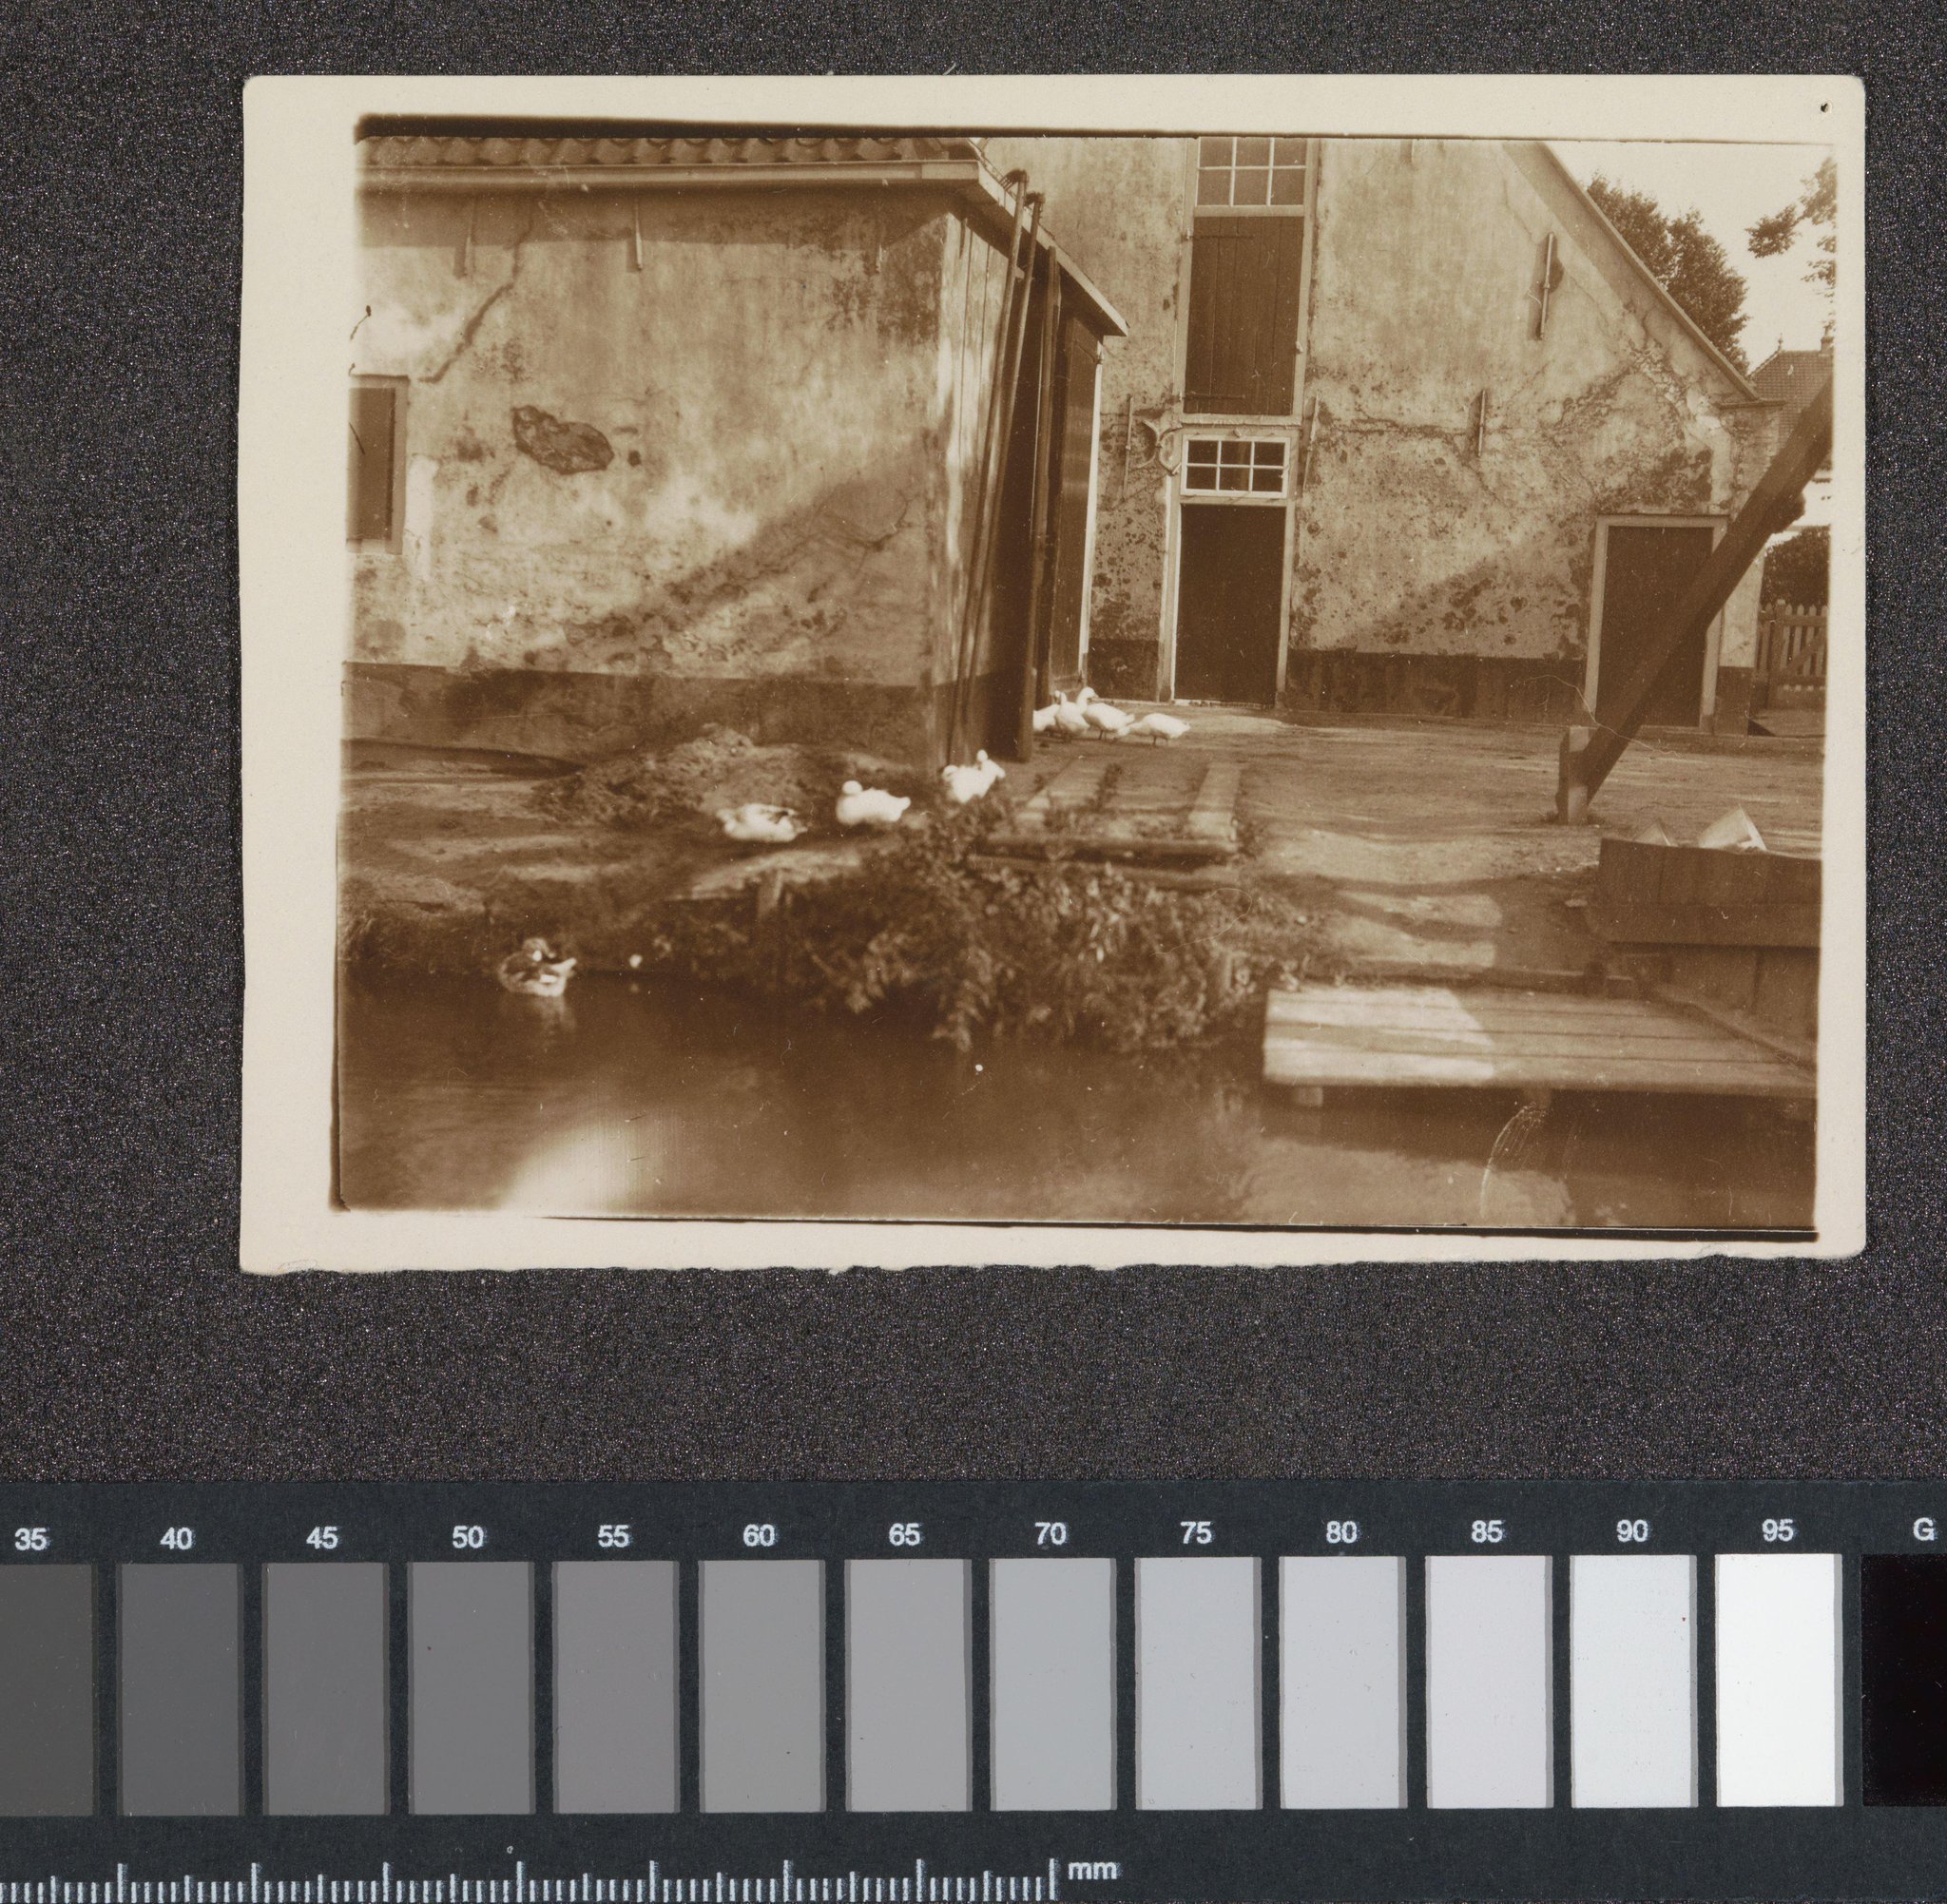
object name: photograph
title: Bij Voorburg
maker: h.c. wilkens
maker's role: amateurfotograaf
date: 1915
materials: photographic support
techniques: gelatin silver print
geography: voorburg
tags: civic architecture; edifices; dwellings